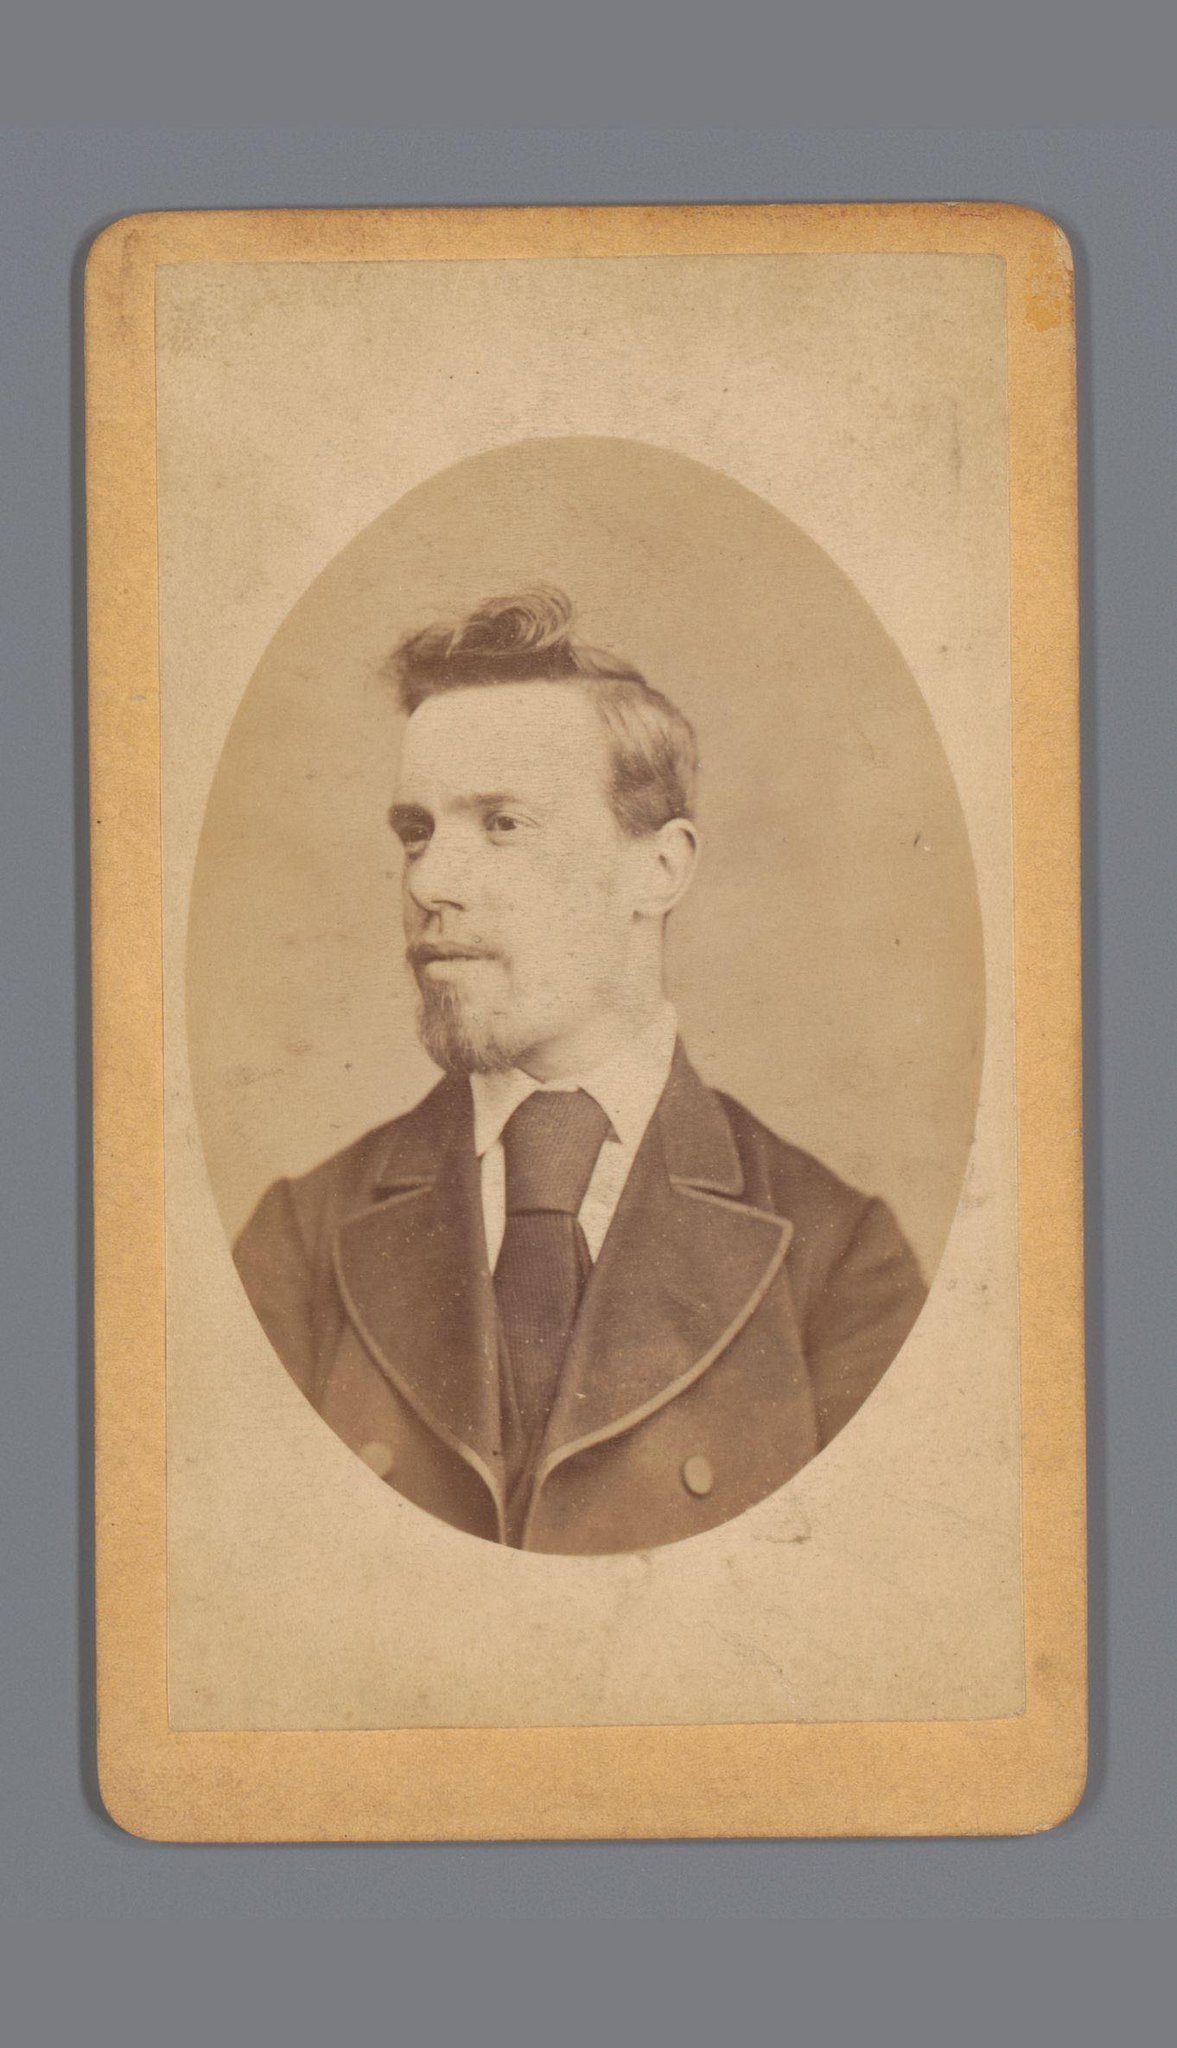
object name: photograph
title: Portret van een onbekende man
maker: john george kirby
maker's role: fotograaf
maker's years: 1849-1913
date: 1855-1885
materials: cardboard, paper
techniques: albumen print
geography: london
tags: adult man, anonymous historical person portrayed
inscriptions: inscription: ‘Portrait, Landscape & Architectural Photographs/ J. G. KIRBY/ 295,/ EDGWARE ROAD/ LONDON,/ W.’